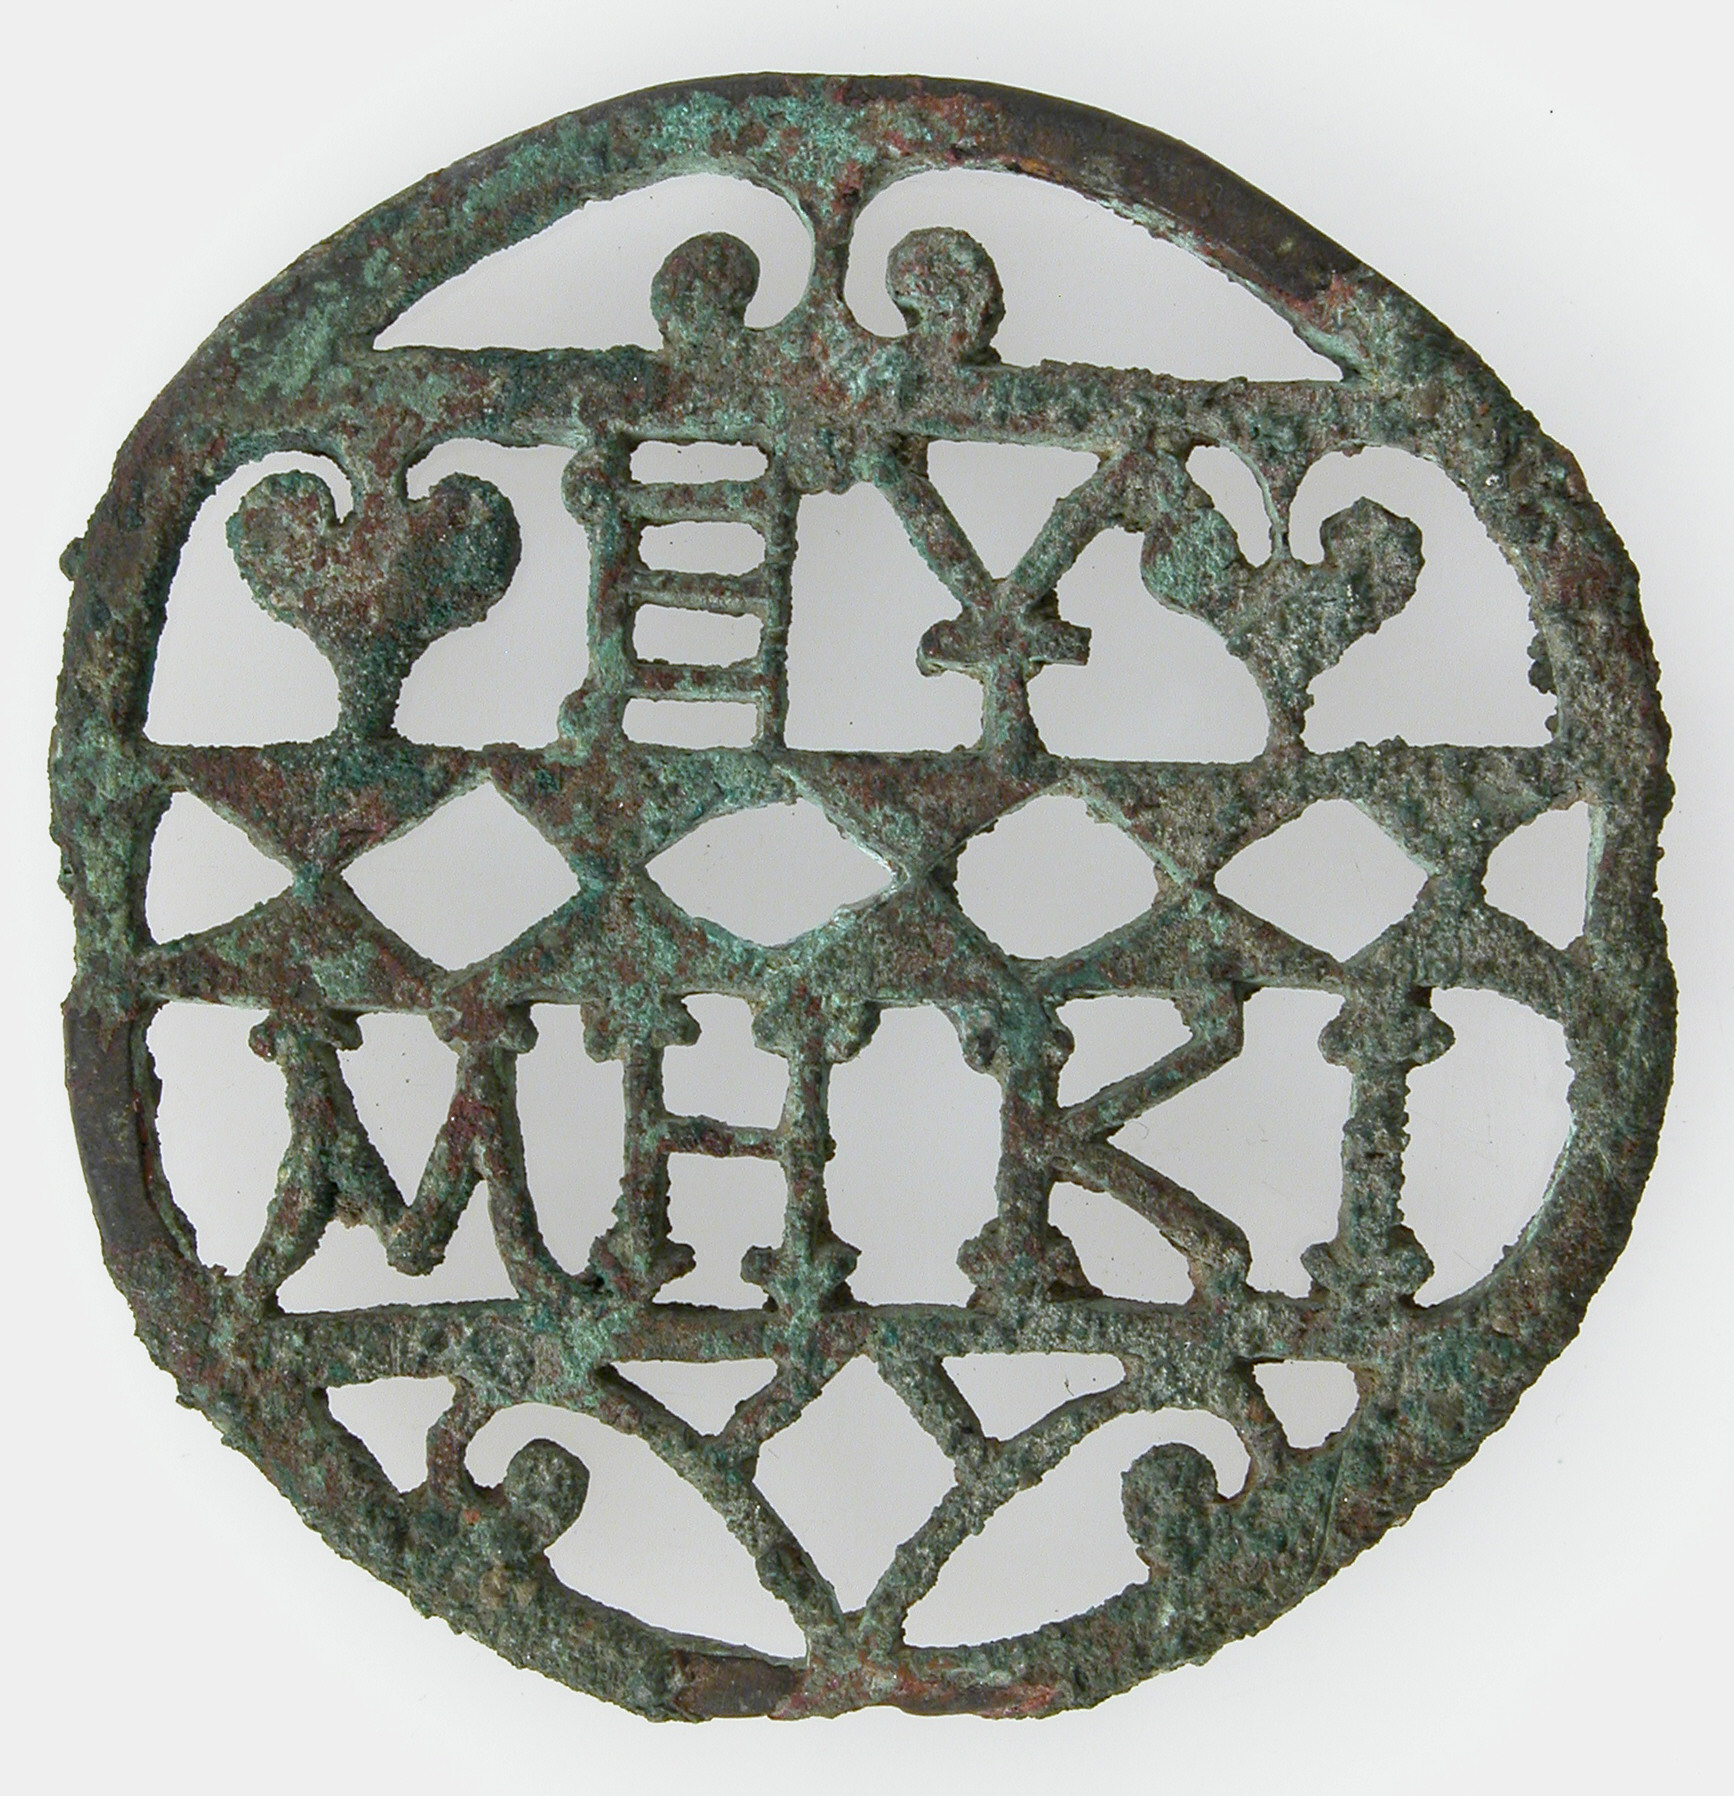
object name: censer and top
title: Censer Top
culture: byzantine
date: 401-600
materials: copper alloy